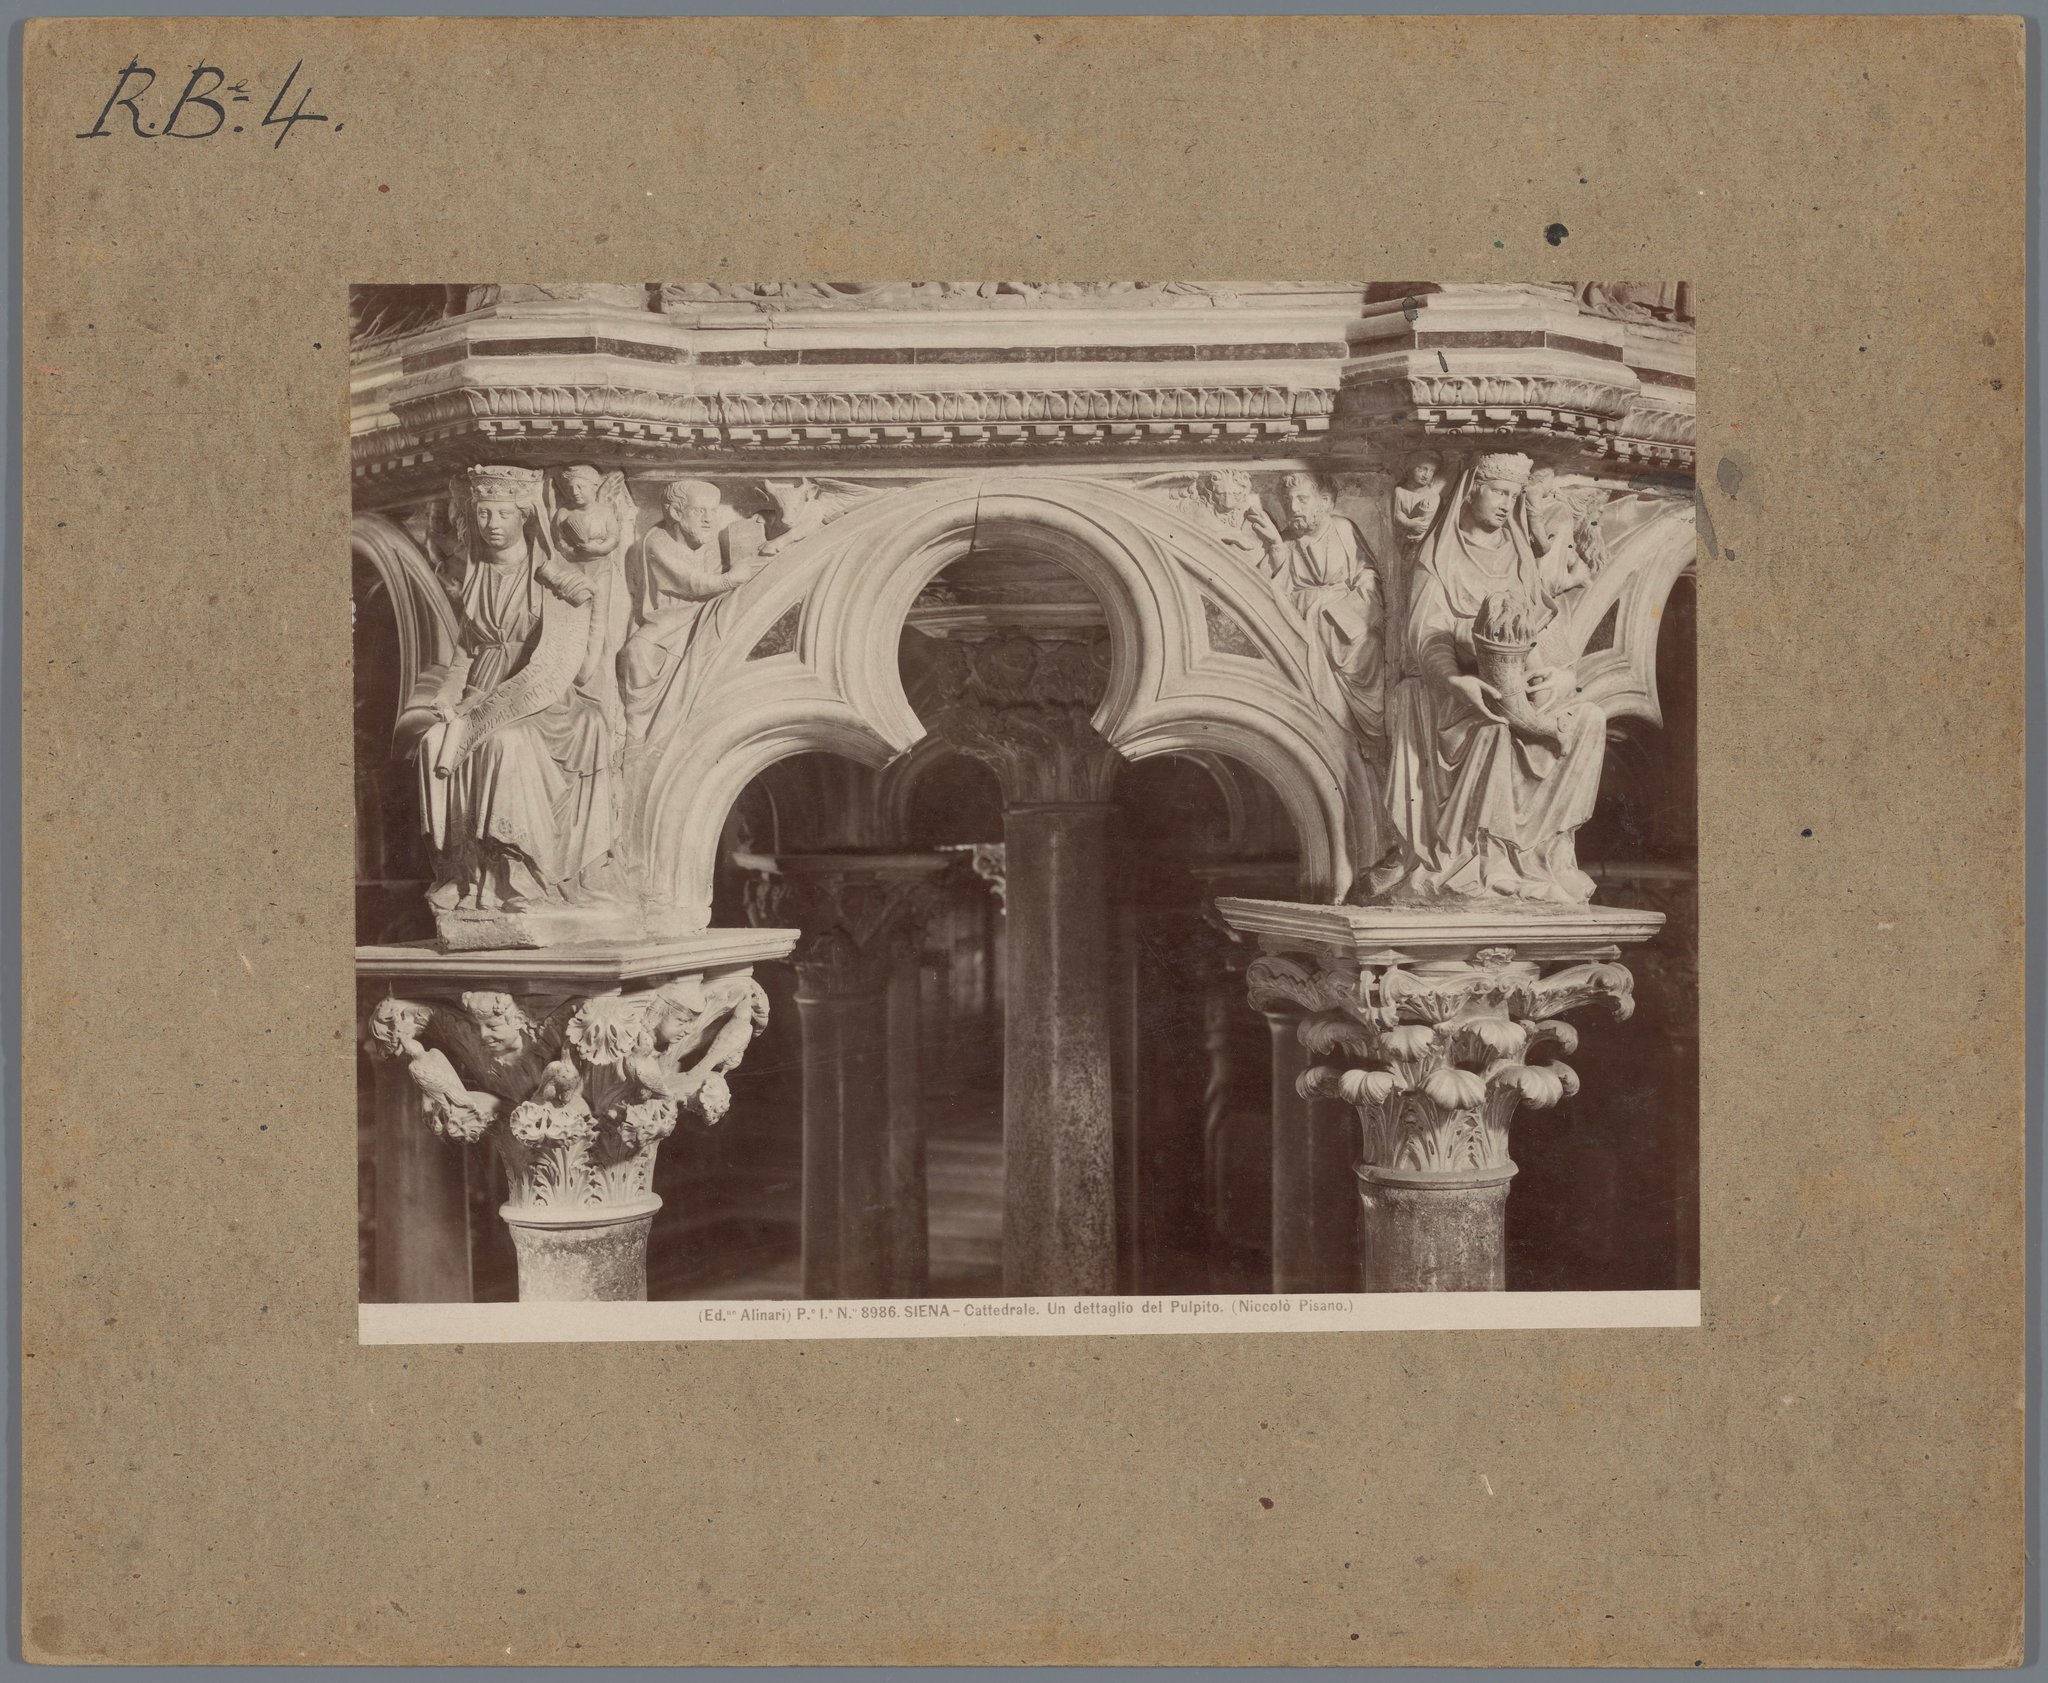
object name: photograph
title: SIENA - Cattedrale. Un dettaglio del Pulpito. (Niccolò Pisano.)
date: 1875-1900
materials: cardboard, photographic support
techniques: albumen print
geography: siena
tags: pulpit, ambo, chancel, female saints, sculpture (+ relief ~ sculpture)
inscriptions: inscription: ‘R.B-. 4.’, number: ‘P.e I.a N.o 8986.’, collector's mark: Lugt 3937